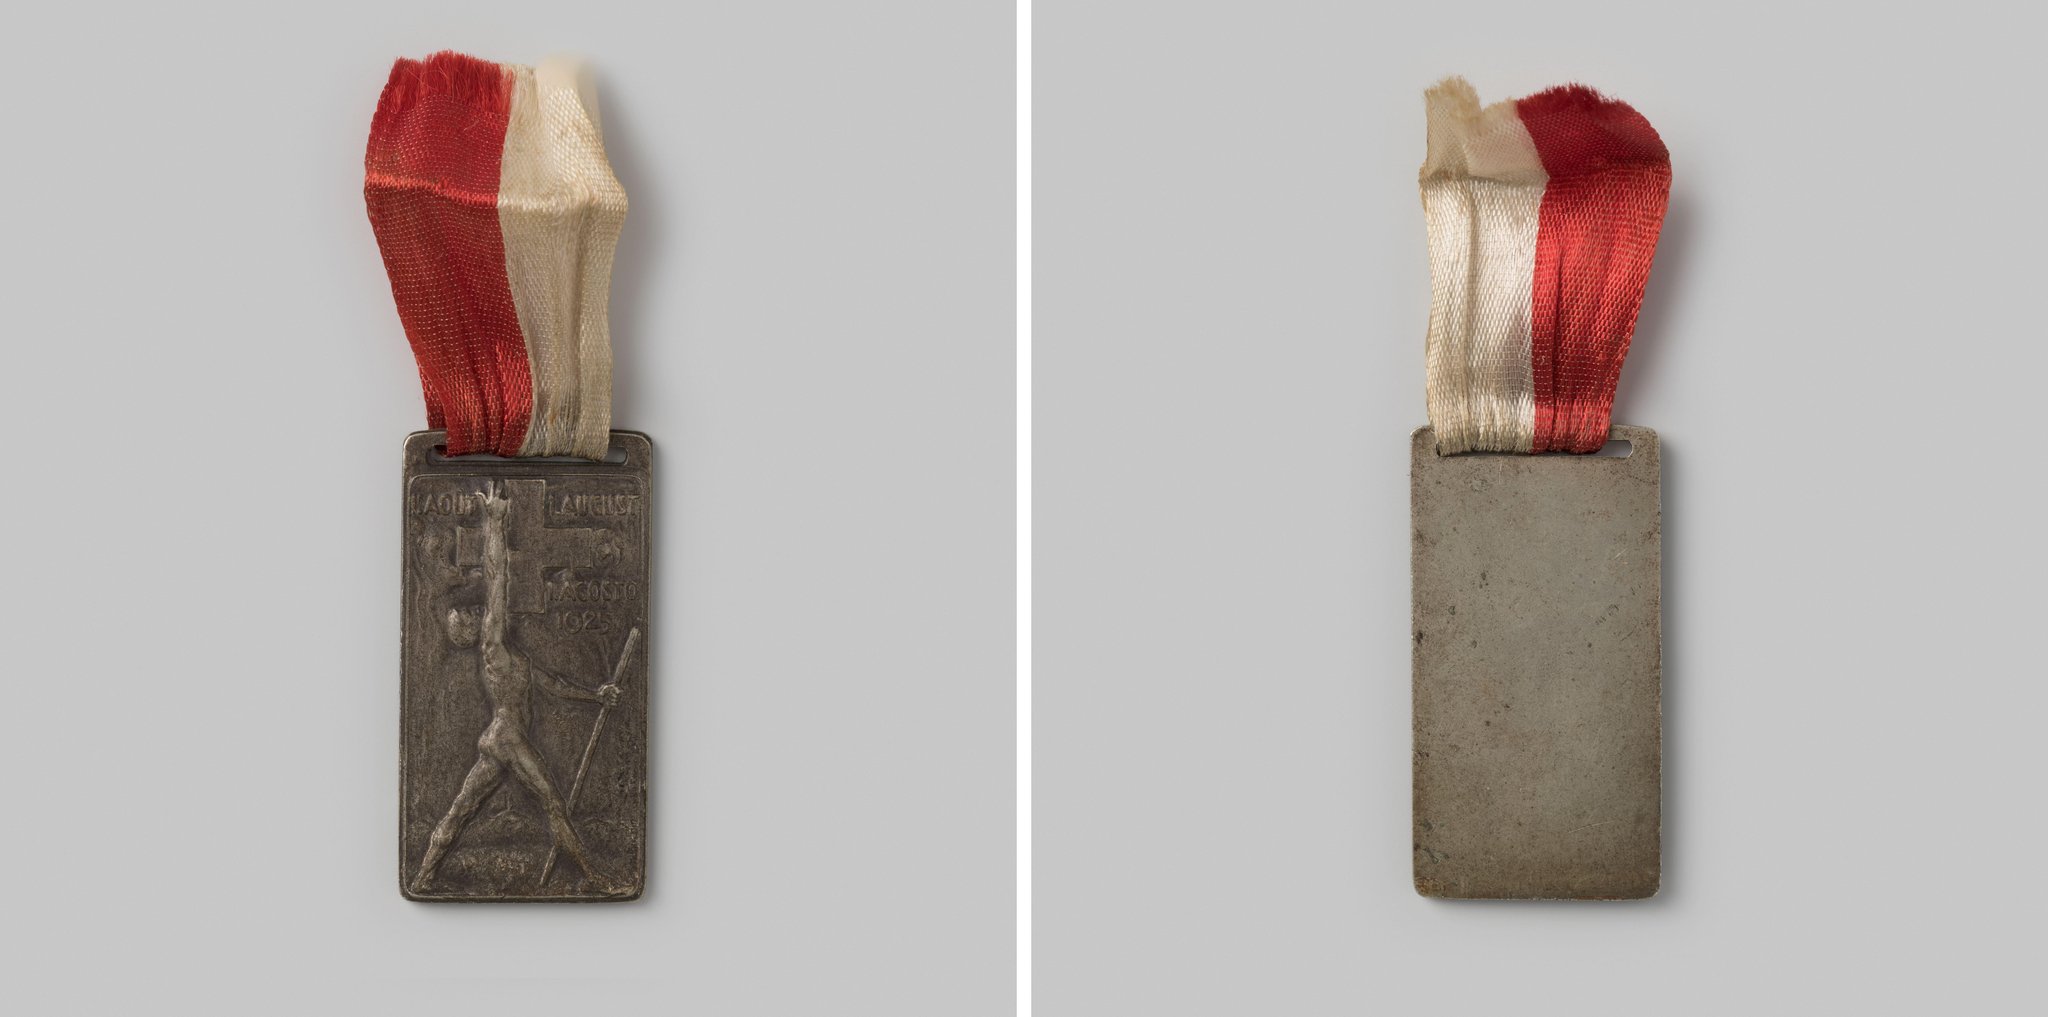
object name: history medal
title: 1 Augustus Zwitserse Nationale Feestdag 1925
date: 1925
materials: metal alloy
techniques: pressing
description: Rechthoekige witmetalen plaquette met gleuf waardoor een rood-wit lint, op de voorzijde een man met wandelstok omhoogwijzend naast een Zwitsers kruis, met drie regels tekst, de keerzijde blanco.